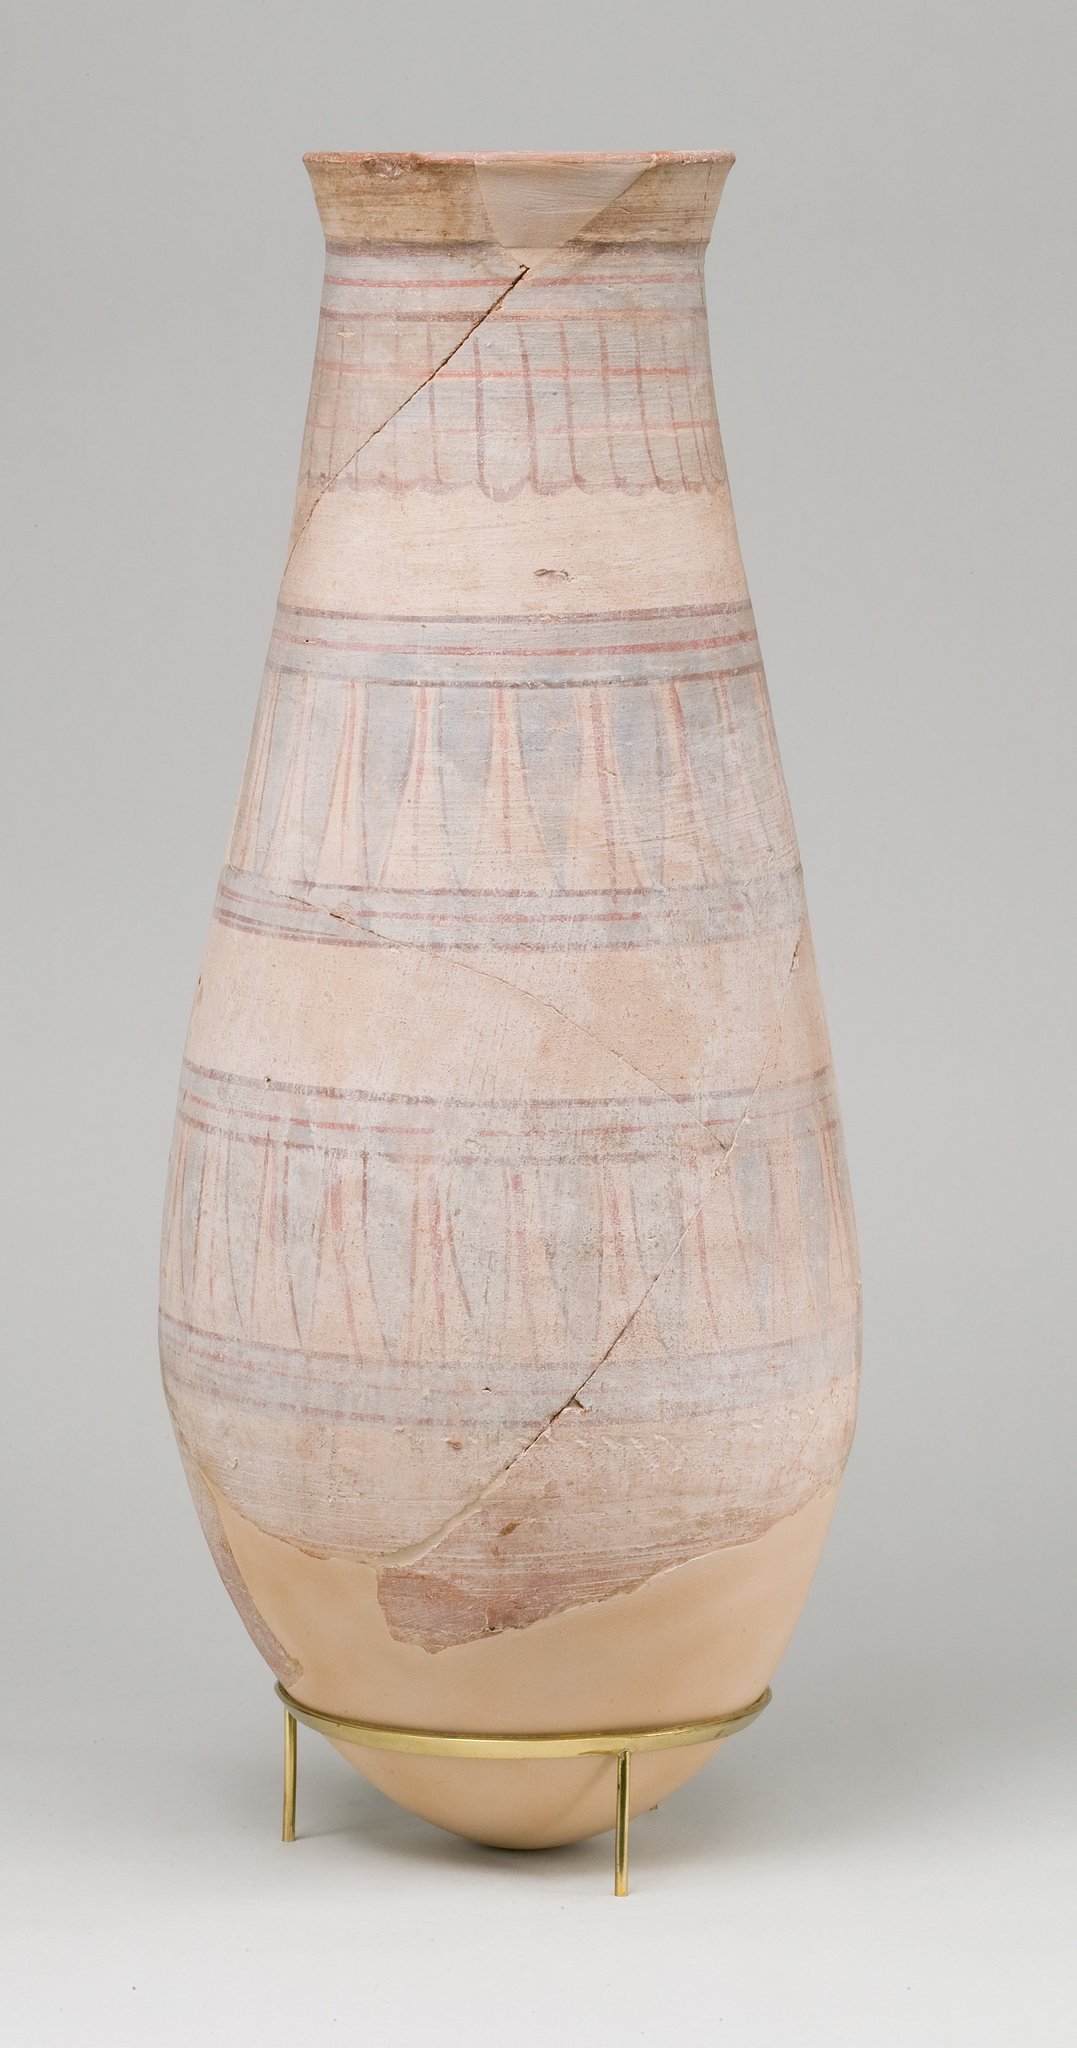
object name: jar, blue painted, malqata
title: Blue-Painted Jar from Malqata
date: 1390-1352 BCE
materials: paint, pottery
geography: egypt